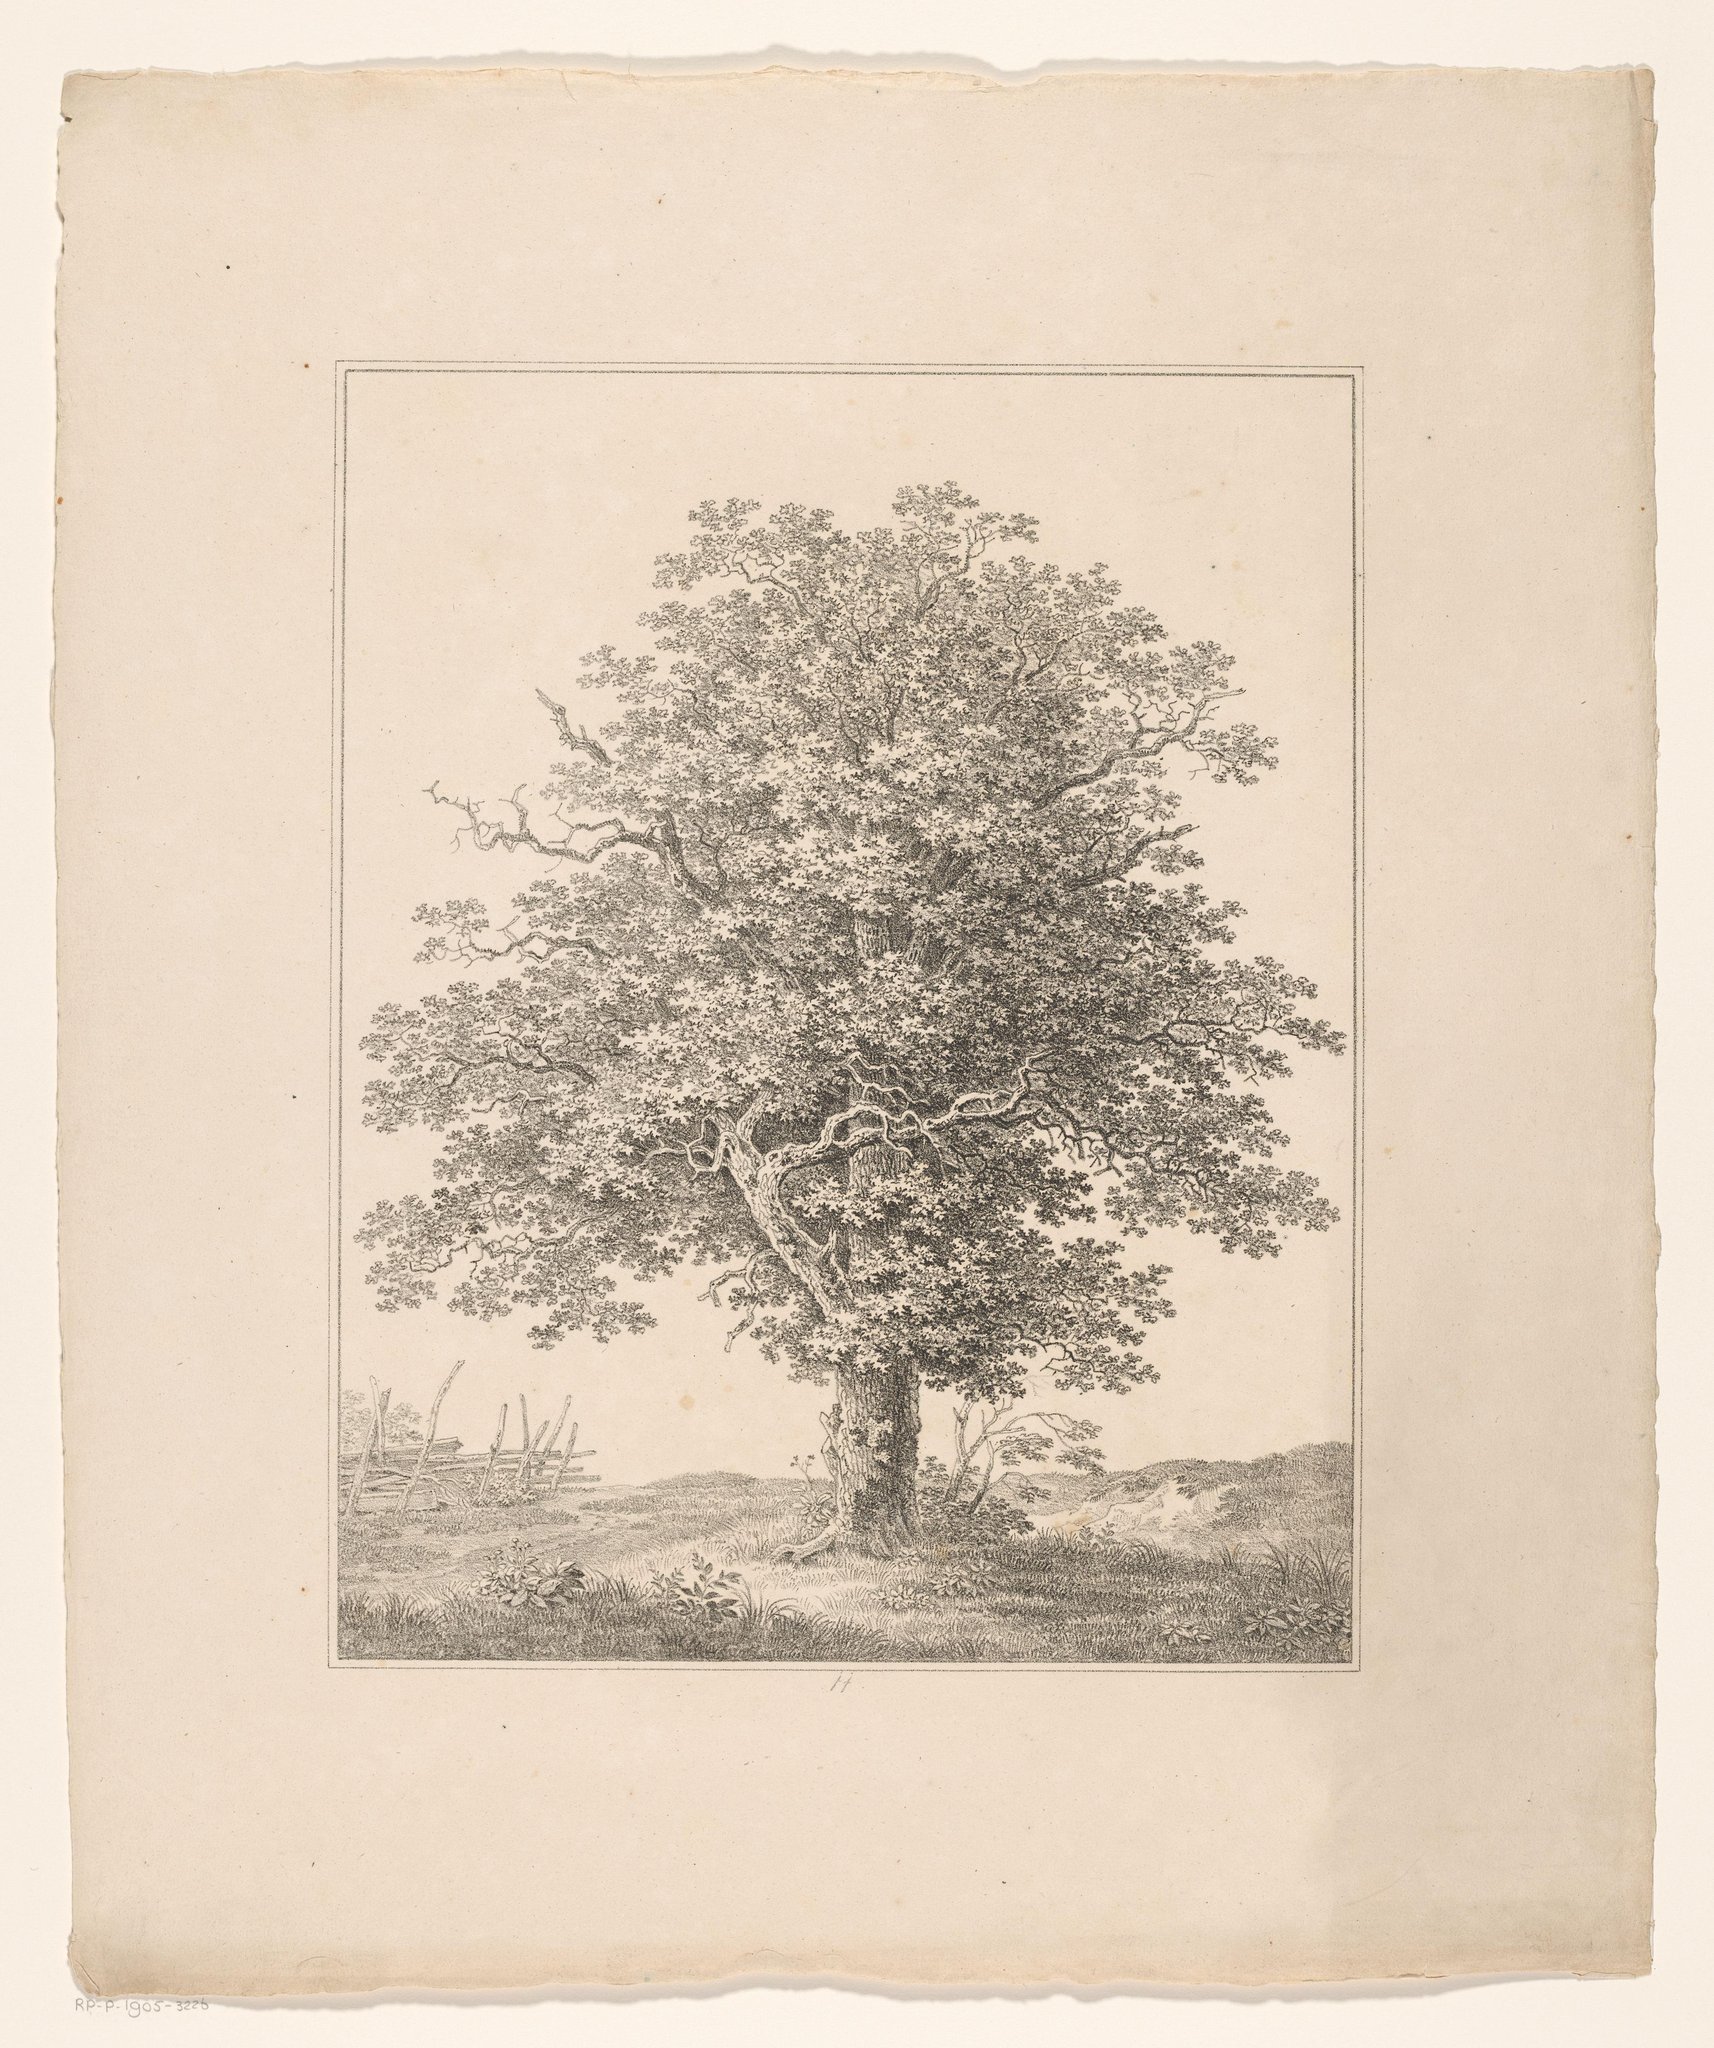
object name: print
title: Boom bij hek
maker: adrianus van der koogh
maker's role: draughtsman, print maker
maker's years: 1796-1831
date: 1826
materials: paper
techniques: lithograph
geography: dordrecht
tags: trees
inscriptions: collector's mark: Lugt 2228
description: In een landschap een boom met links een hek.